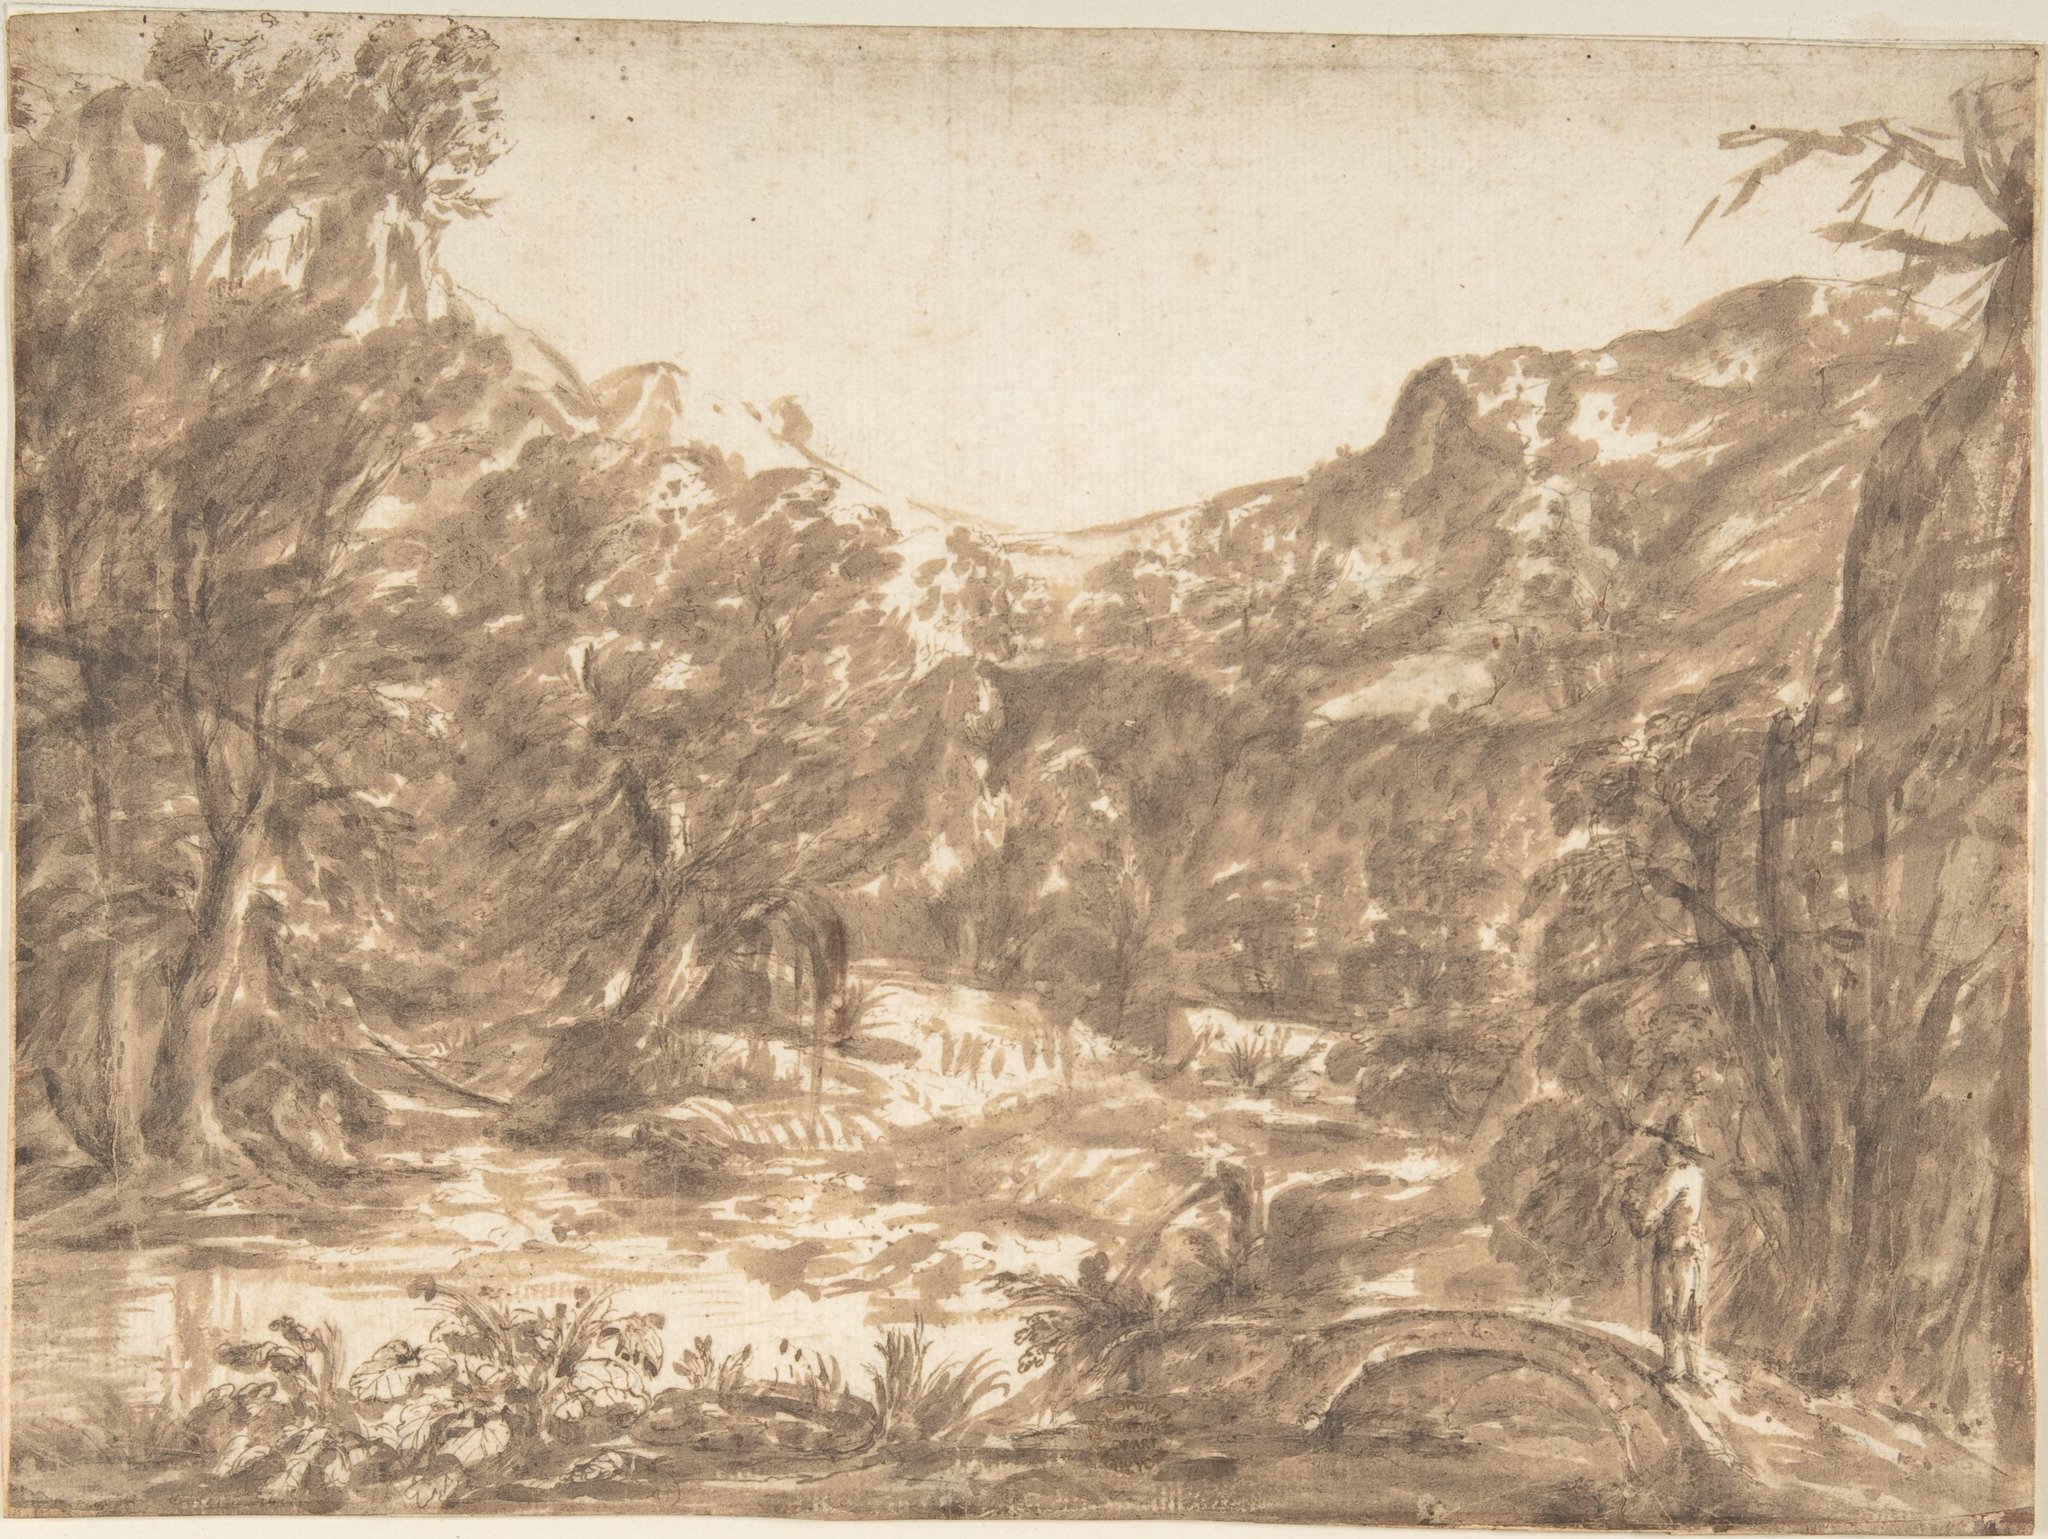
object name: drawing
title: Landscape with Figure Standing on a Bridge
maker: anonymous, italian, roman-bolognese, 17th century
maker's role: artist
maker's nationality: italian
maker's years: 1600-1700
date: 1601-1700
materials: chalk, ink, paper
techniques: brush, pen, wash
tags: bridges,landscapes